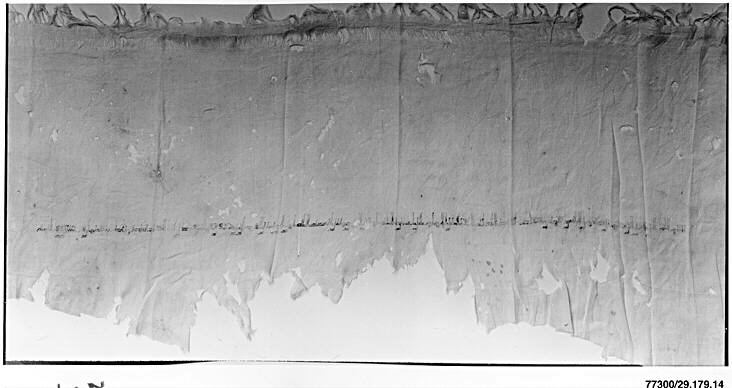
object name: textile fragment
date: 934-940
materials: linen, silk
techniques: weave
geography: egypt